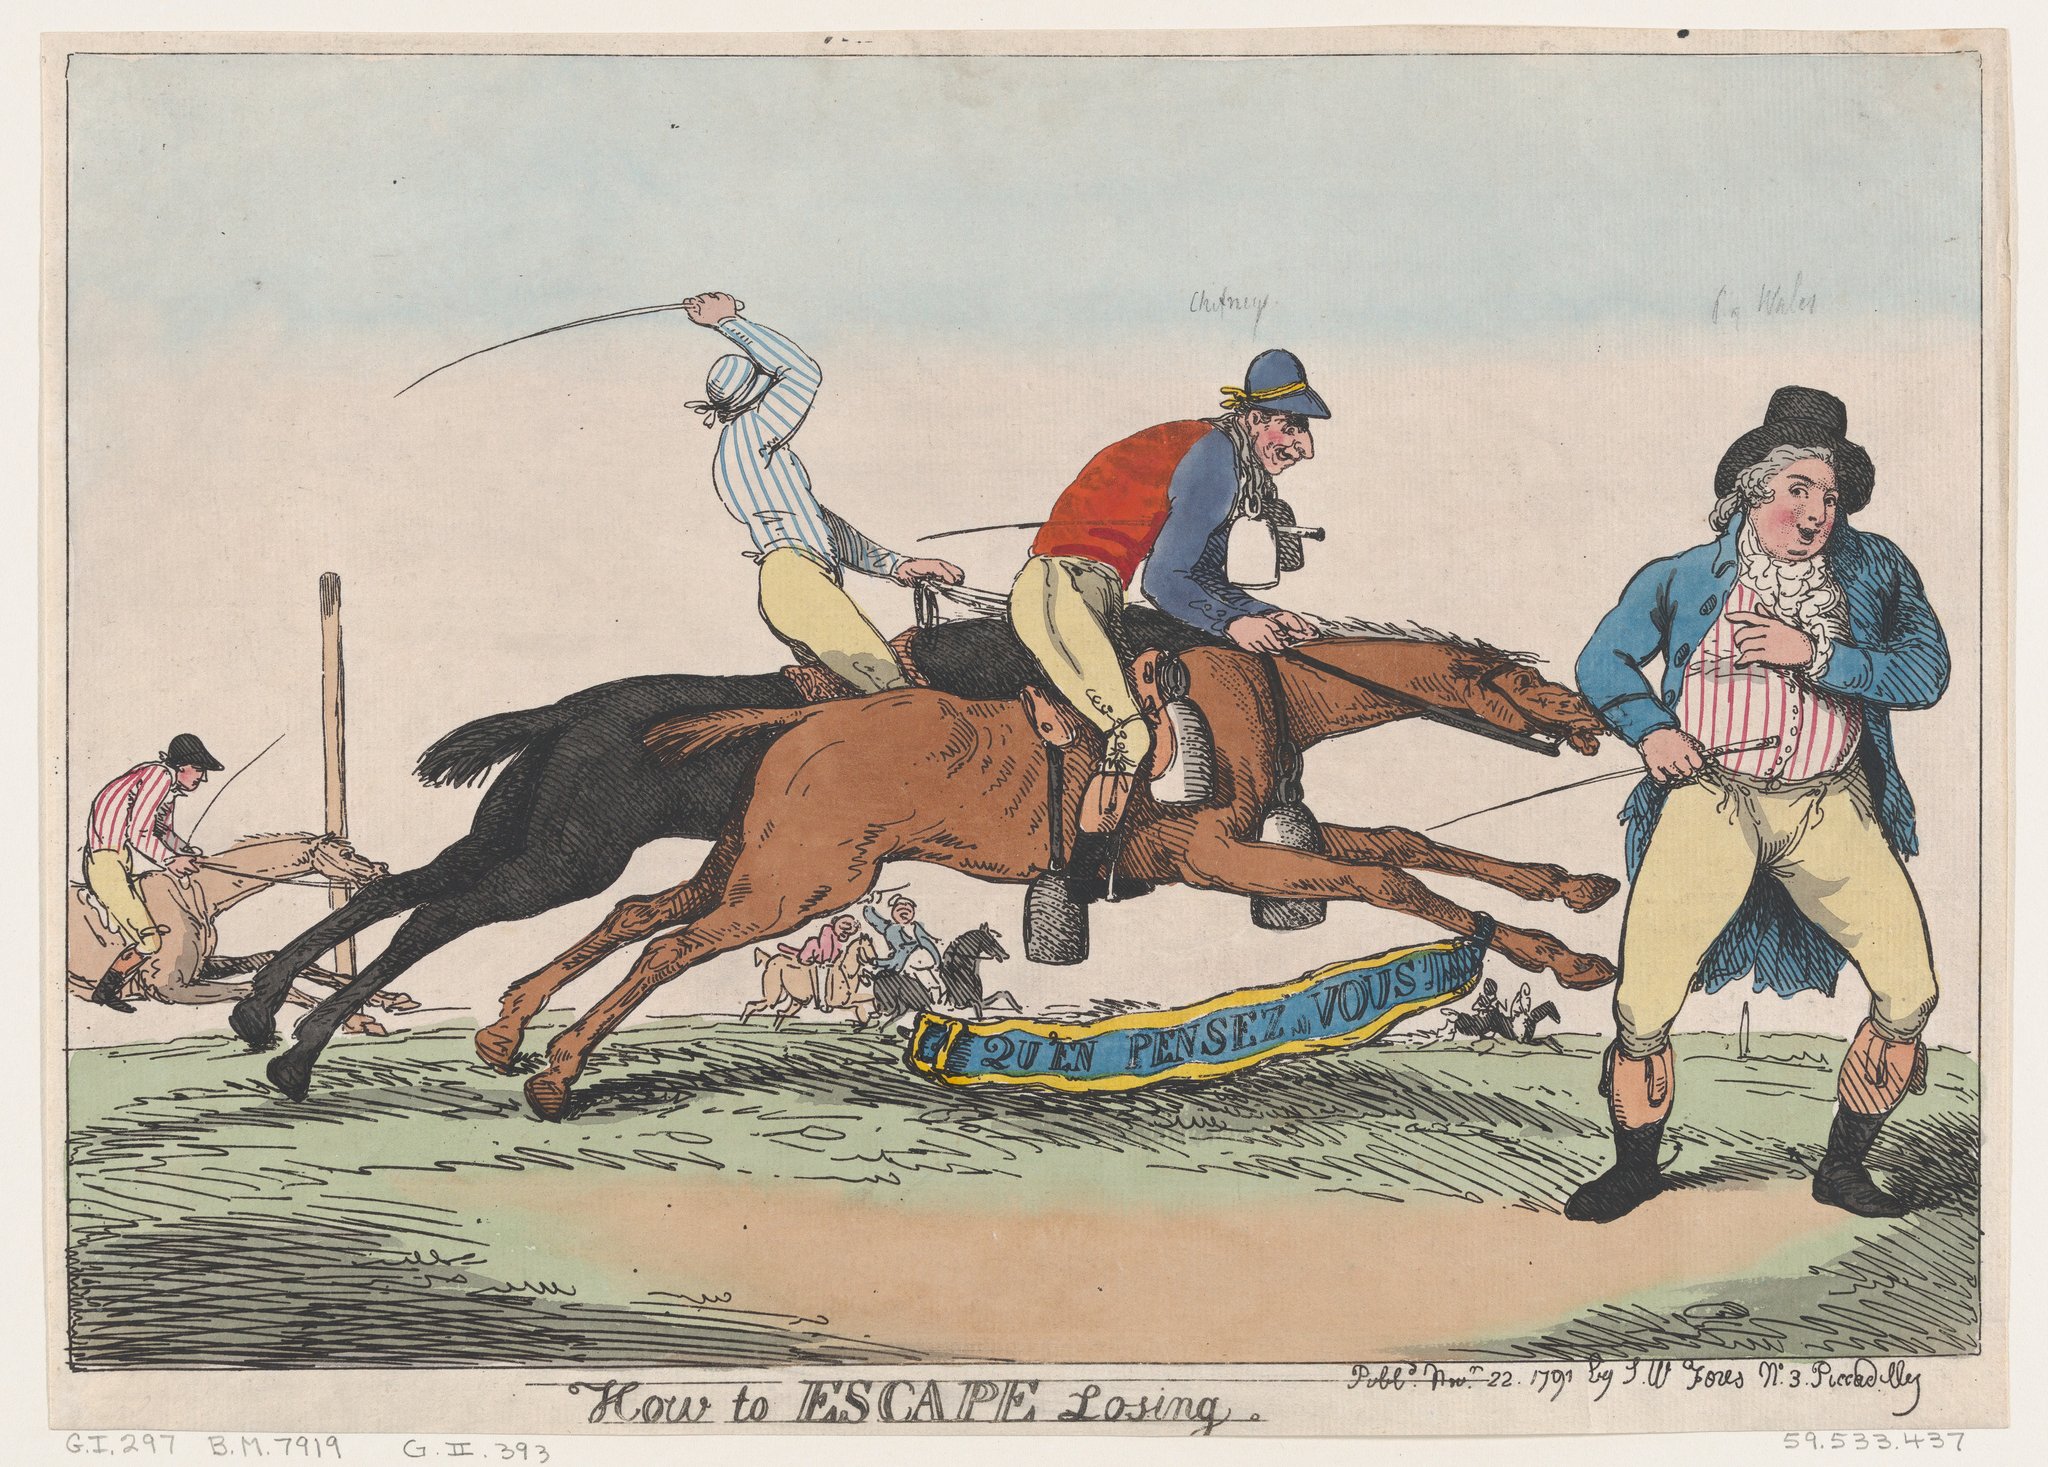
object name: print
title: How to Escape Losing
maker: thomas rowlandson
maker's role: artist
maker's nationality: british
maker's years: 1757-1827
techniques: aquatint, etching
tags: satire,men,horses